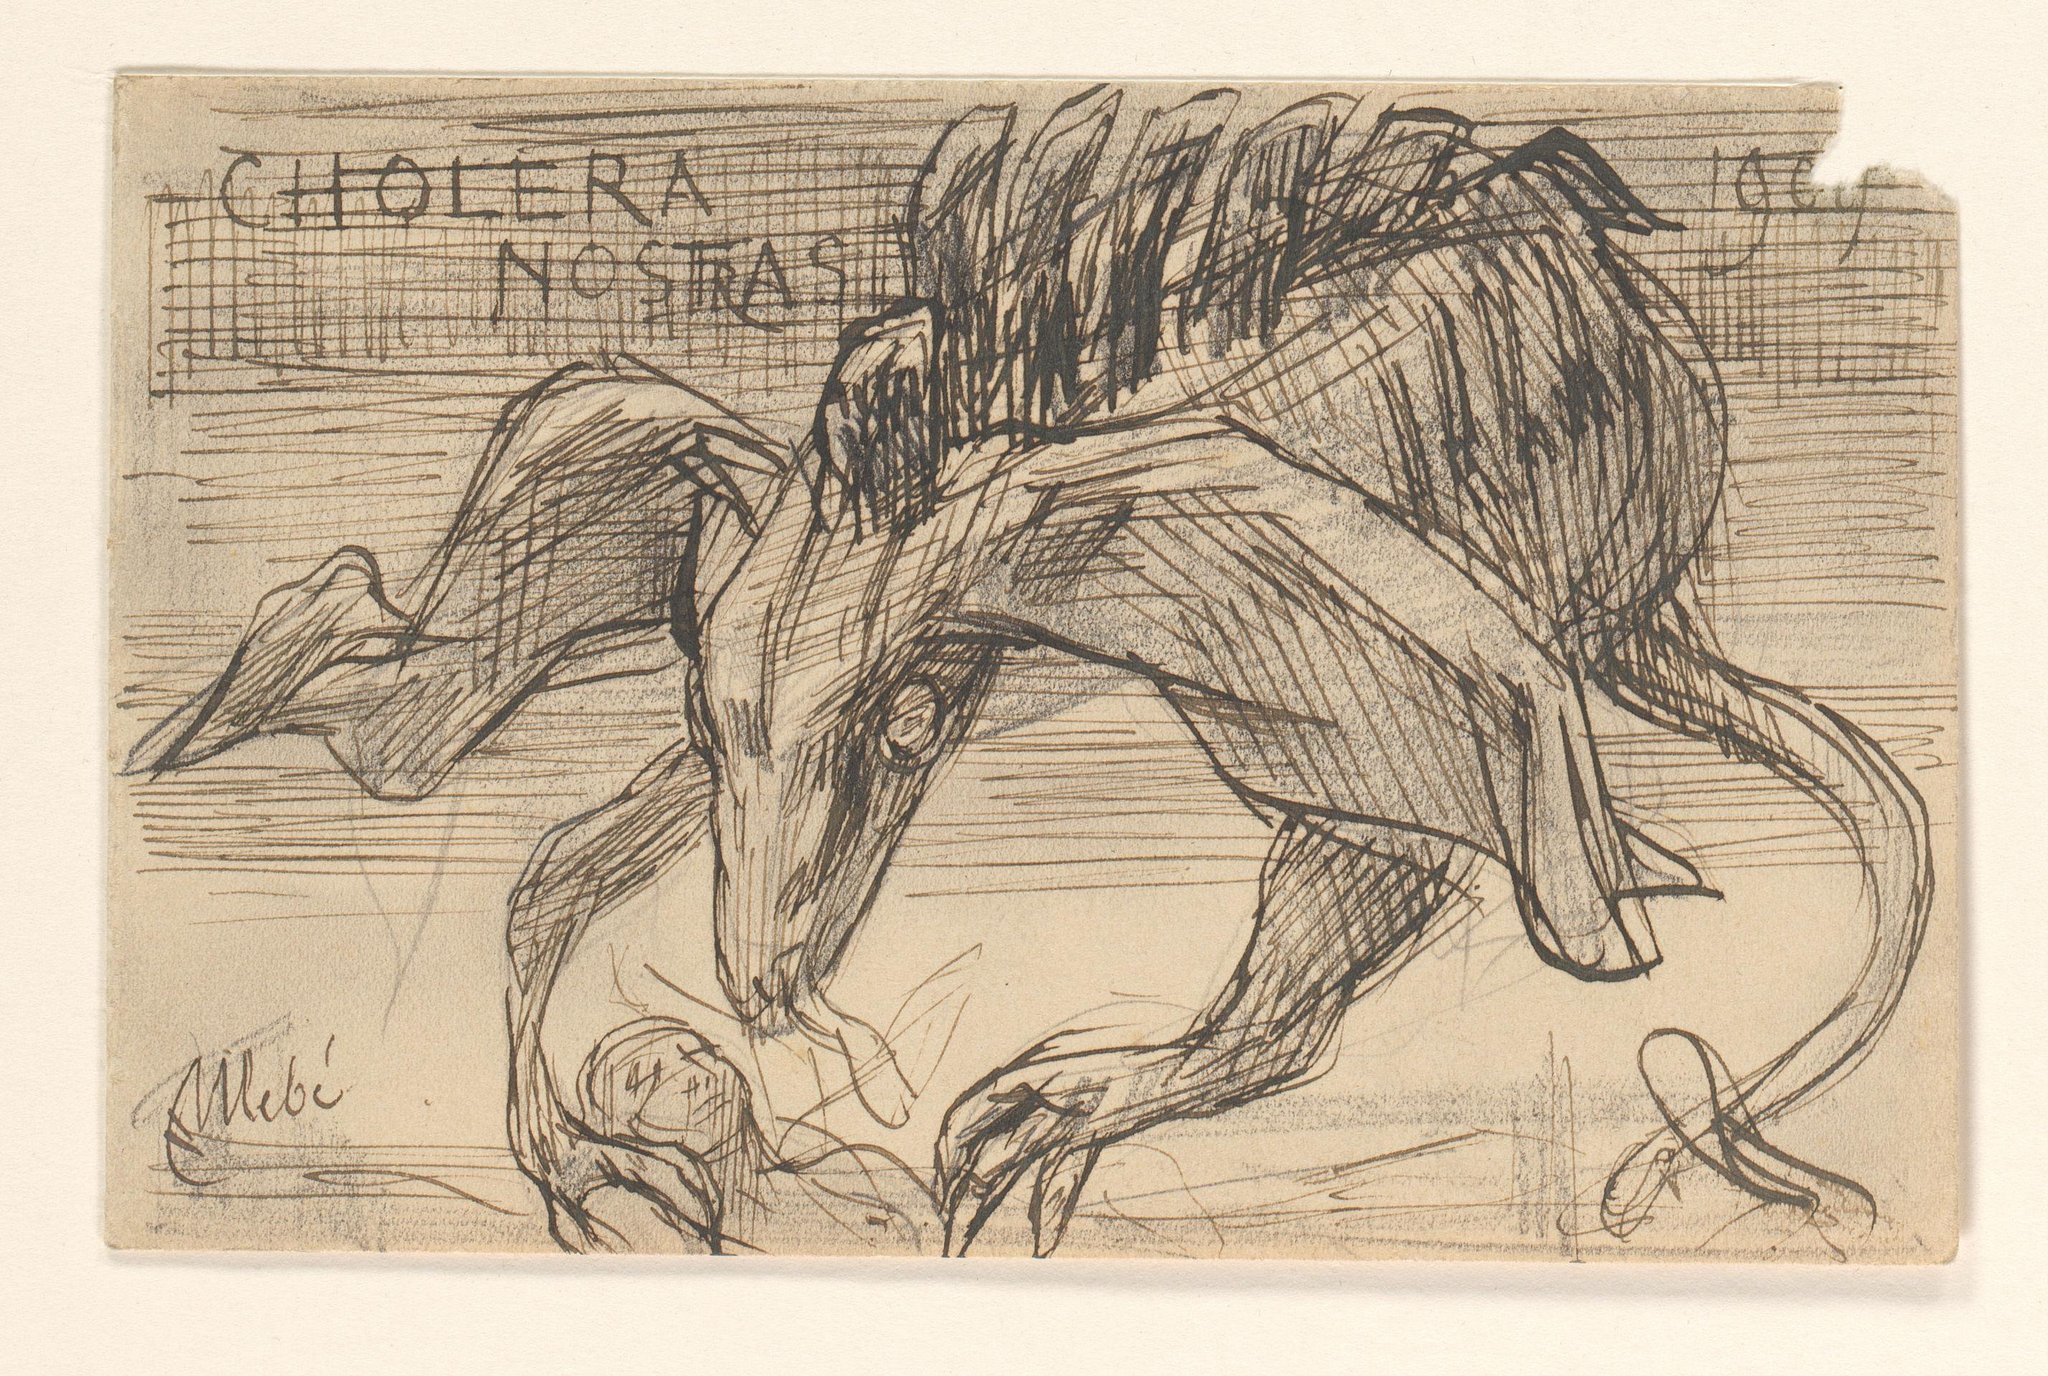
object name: drawing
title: Cholera Nostras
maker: august allebé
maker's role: draughtsman, print maker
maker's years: 1838-1927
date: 1909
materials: ink, paper, pencil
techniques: pen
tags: fabulous animals (sometimes wrongly called 'grotesques'); 'mostri' (ripa)